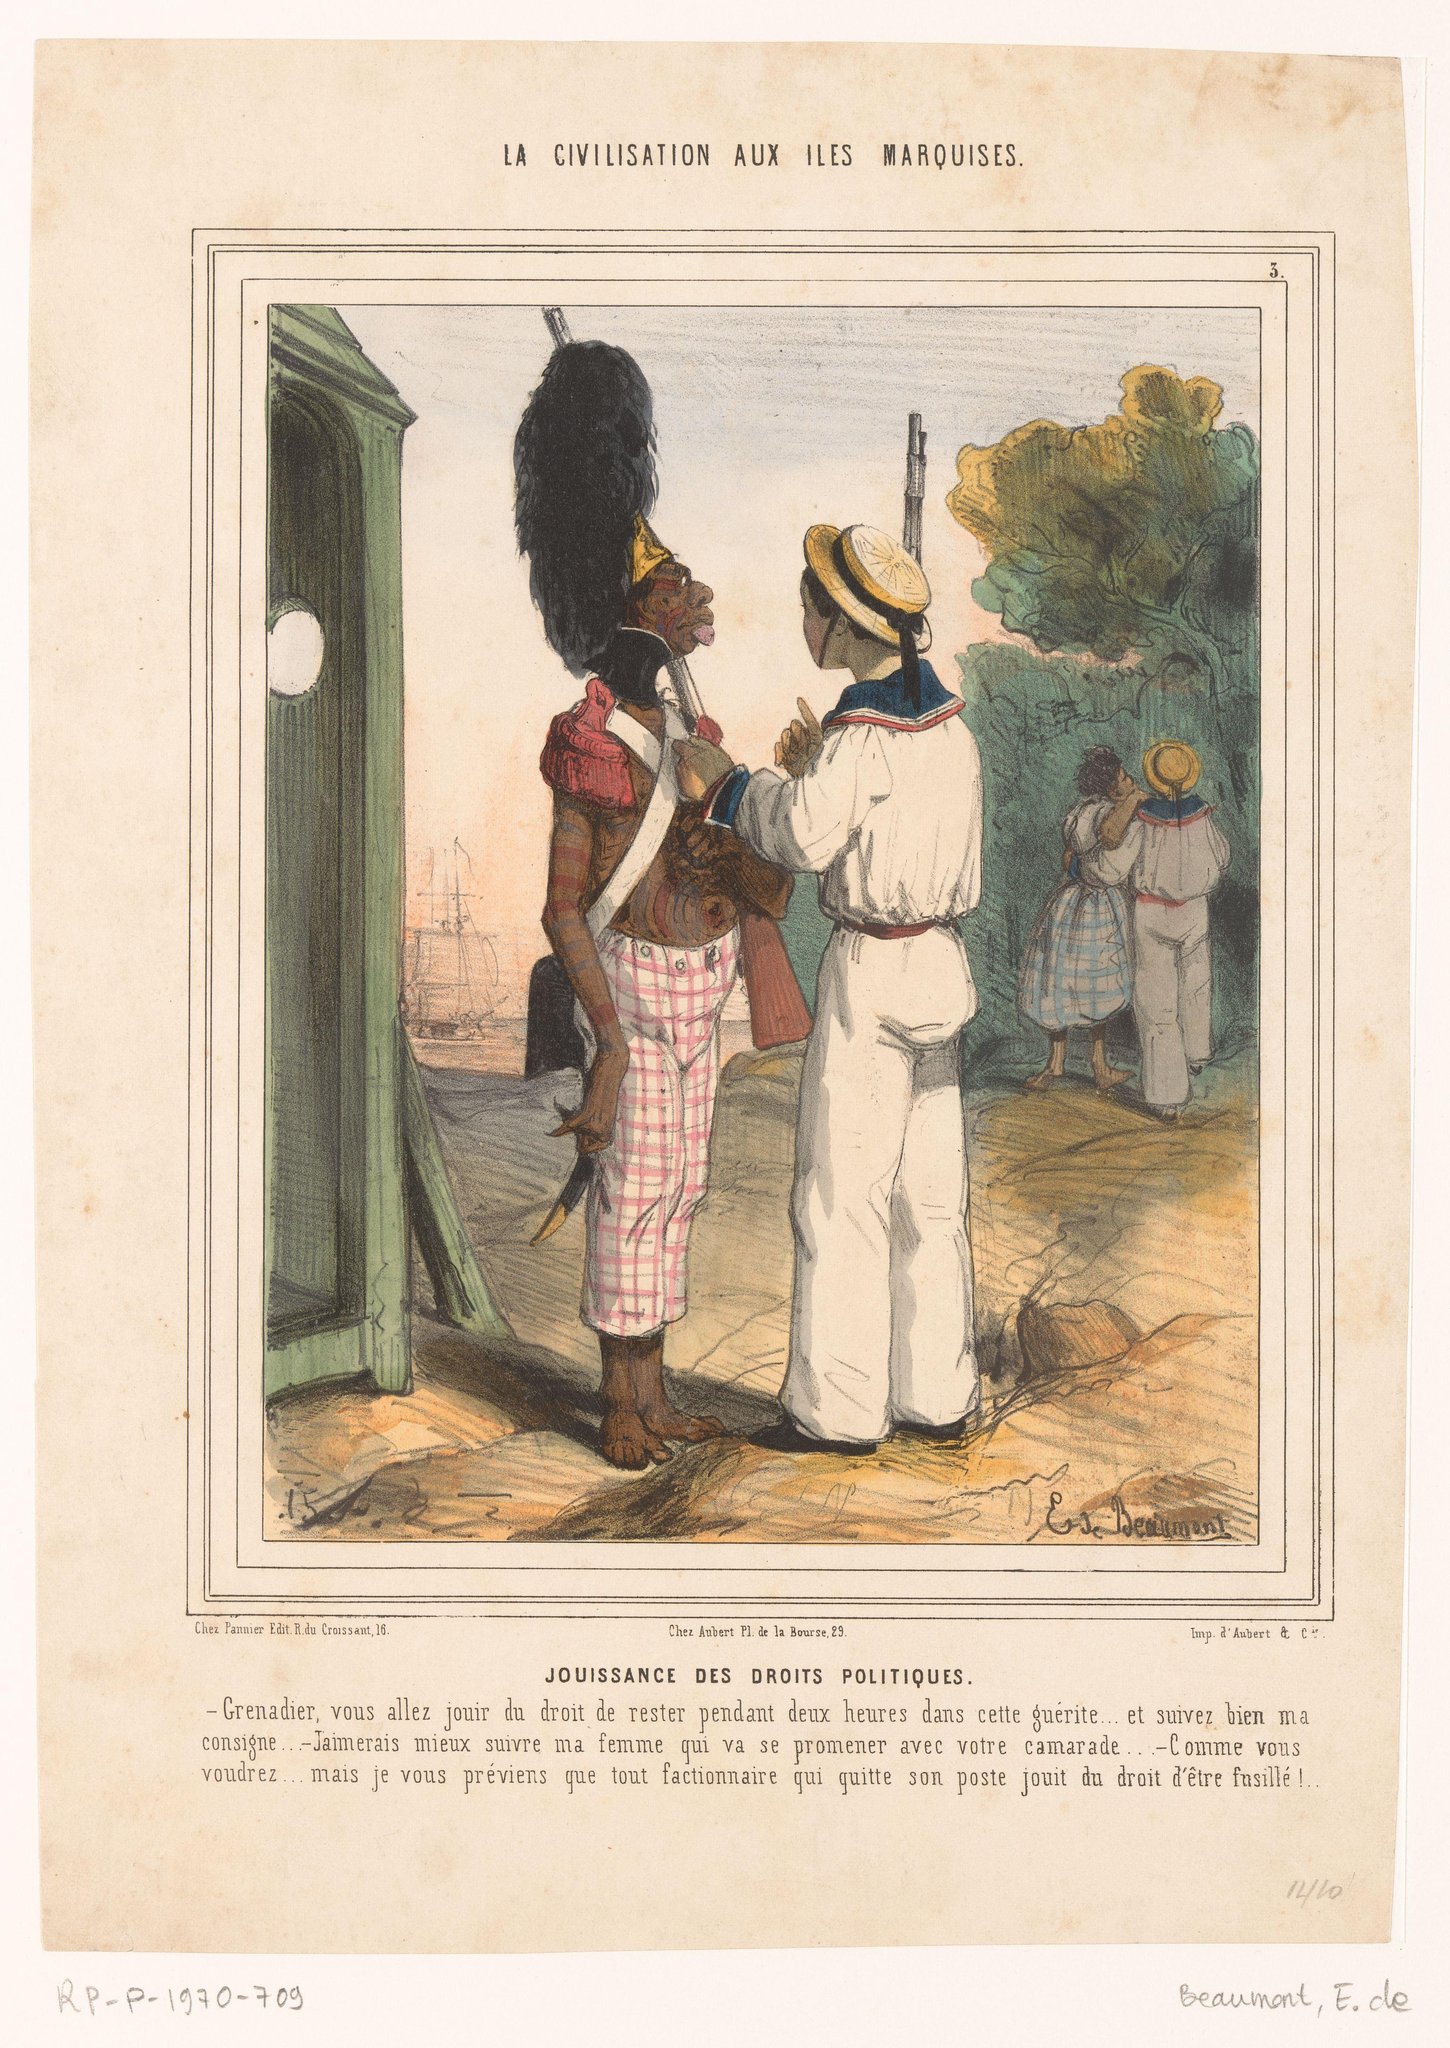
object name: cartoon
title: Karikatuur van een grenadier die op zijn post moet blijven staan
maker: edouard de beaumont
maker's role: draughtsman, painter, print maker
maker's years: 1812-1888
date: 1843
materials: paper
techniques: hand coloring, lithograph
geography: paris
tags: colonial system, australian and oceanian races (+ caricatured), guard duty, keeping sentry, marquesas archipelago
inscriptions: collector's mark: ‘L.A. de Vries’ Lugt 2228a, annotation: ‘v. Stockum, 24 nov. 1964, no. 172 (81 st) f. 520,-.’, collector's mark, number: ‘1410’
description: Een Franse soldaat geeft een oorspronkelijke inwoner van de Markiezenarchipel de instructie om als grenadier op zijn post te blijven staan. De grenadier zou liever achter zijn vrouw aan gaan, die gaat wandelen met een kameraad van de Fransman. De soldaat waarschuwt hem echter dat hij het recht heeft om gefusilleerd te worden als hij zijn wachtpost verlaat.